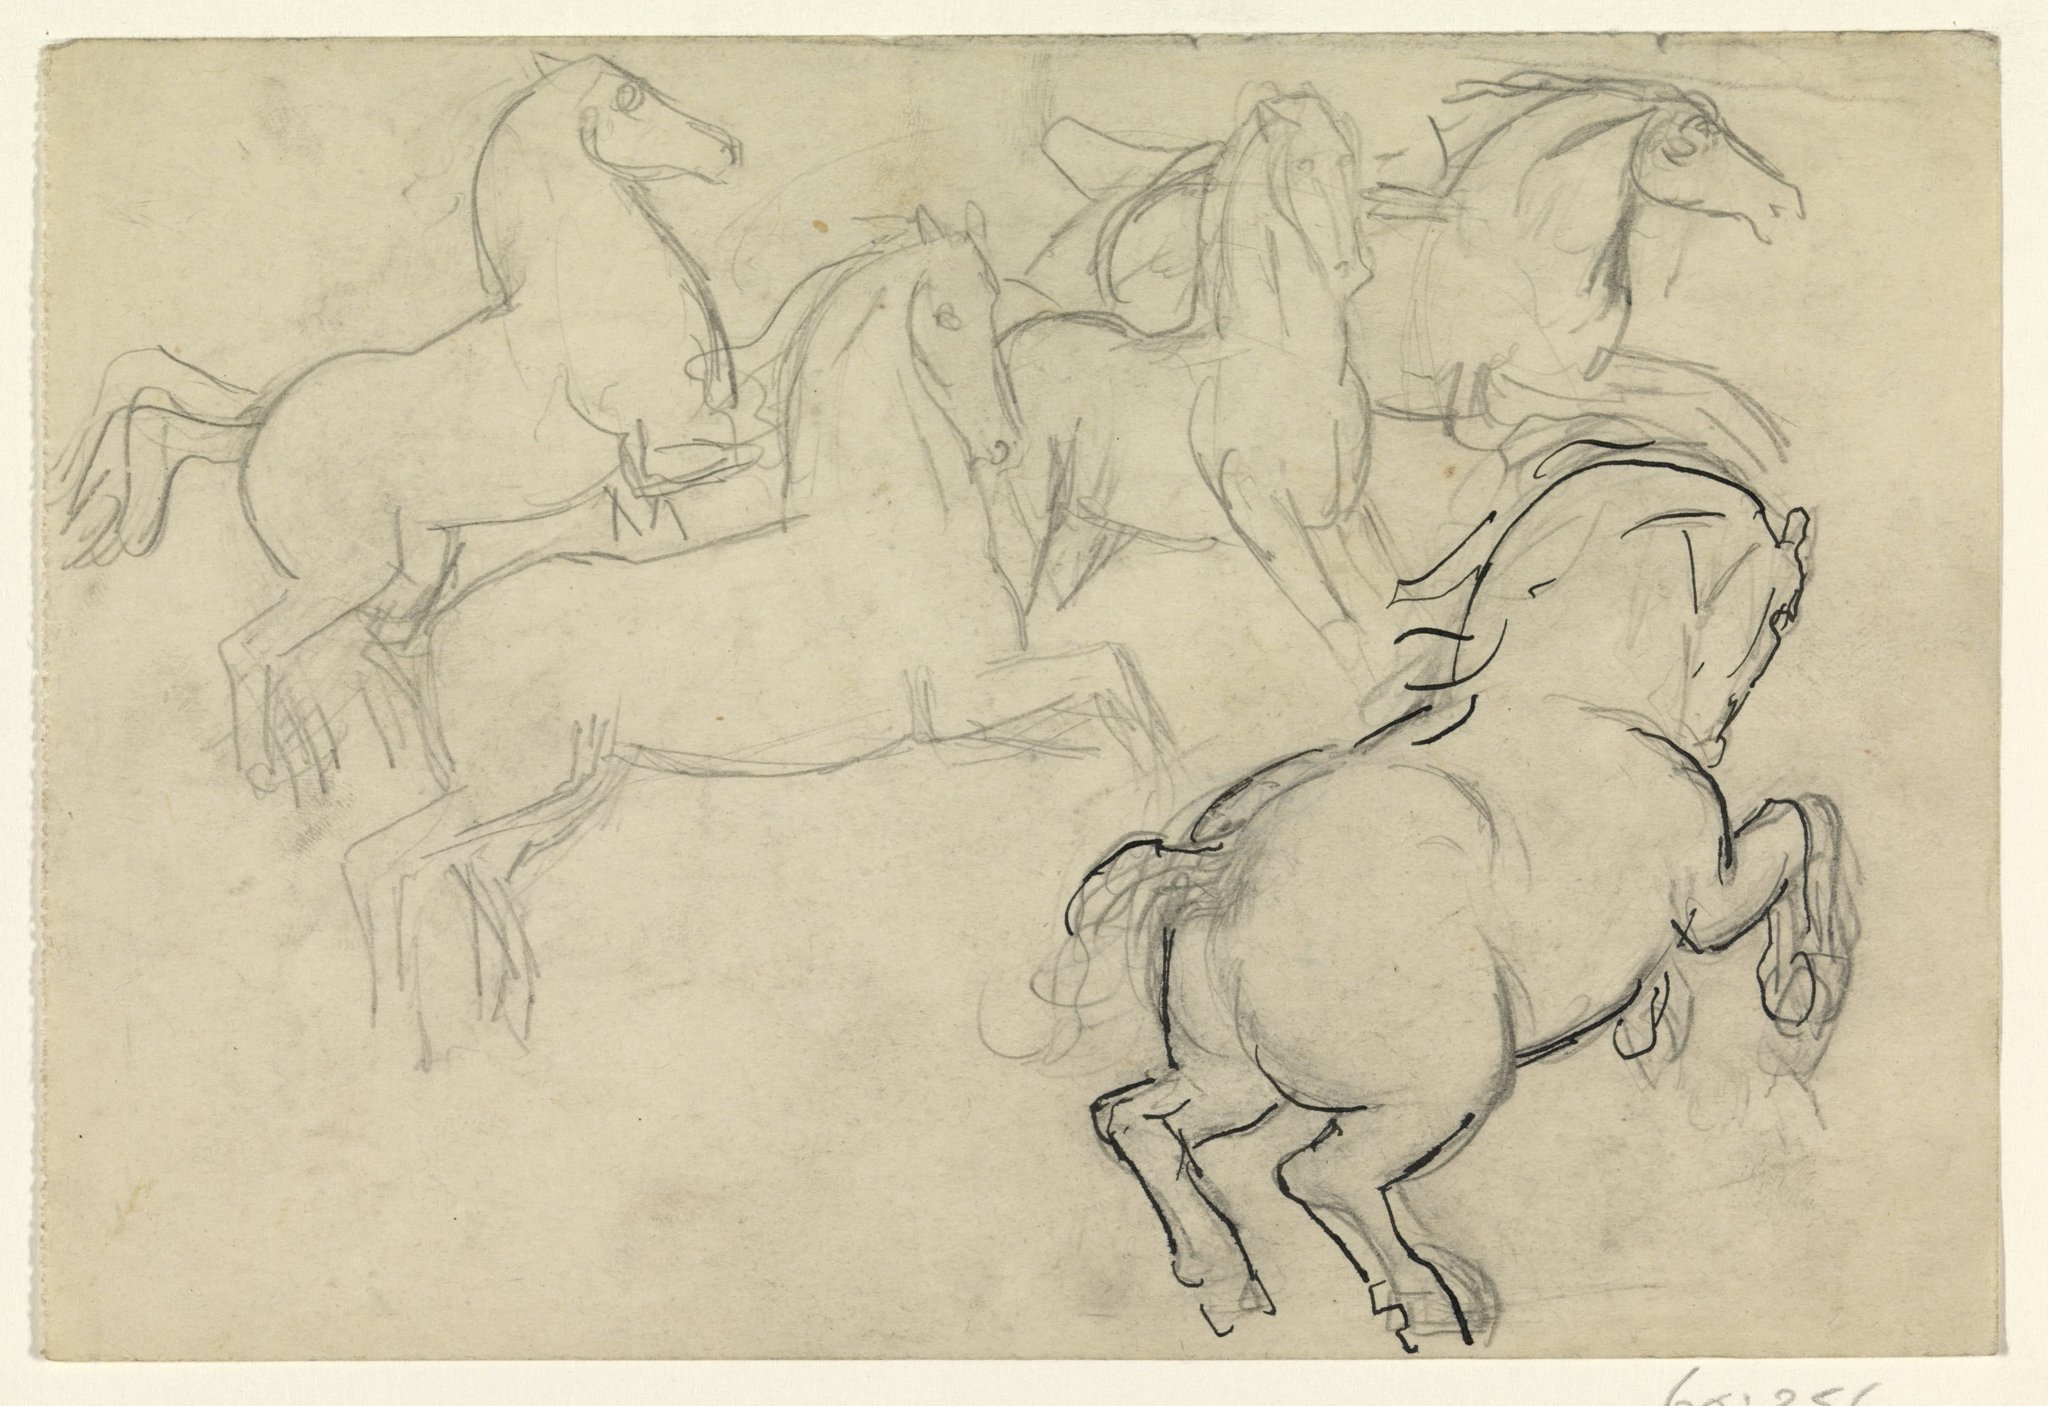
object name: drawing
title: Galopperende paarden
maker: leo gestel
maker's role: draughtsman, print maker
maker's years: 1881-1941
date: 1891-1941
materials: ink, paper, pencil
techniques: pen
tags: galloping horse, horse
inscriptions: collector's mark: Lugt 2228